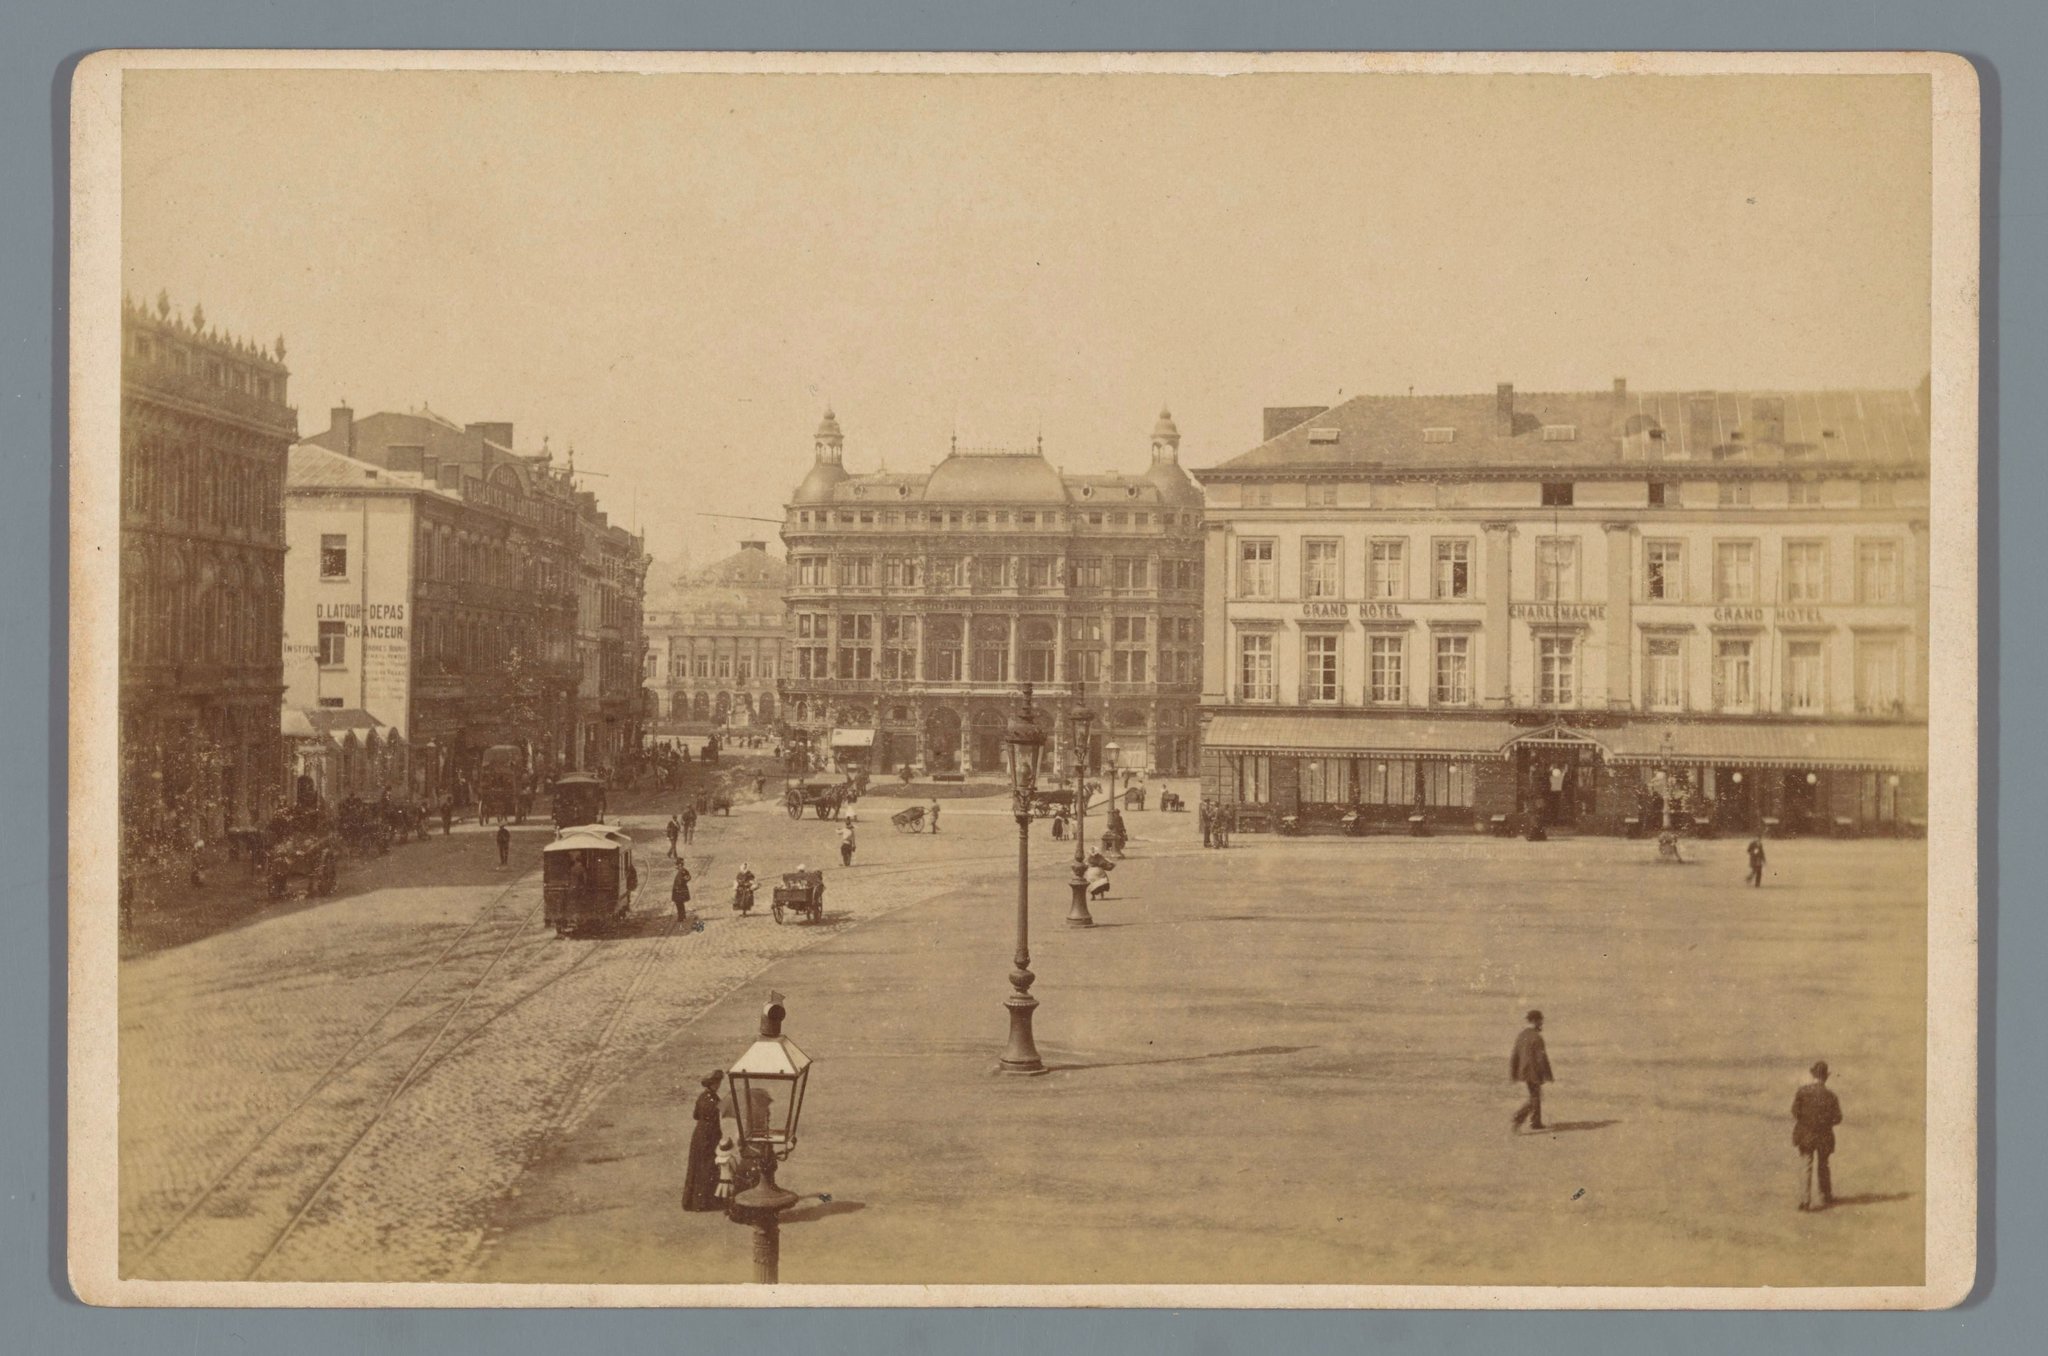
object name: photograph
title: Gezicht op een stadsplein te Straatsburg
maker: Anonymous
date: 1870-1900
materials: cardboard, photographic support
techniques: albumen print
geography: straatsburg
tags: city-view in general; 'veduta'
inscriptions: annotation: ‘Straatsburg’